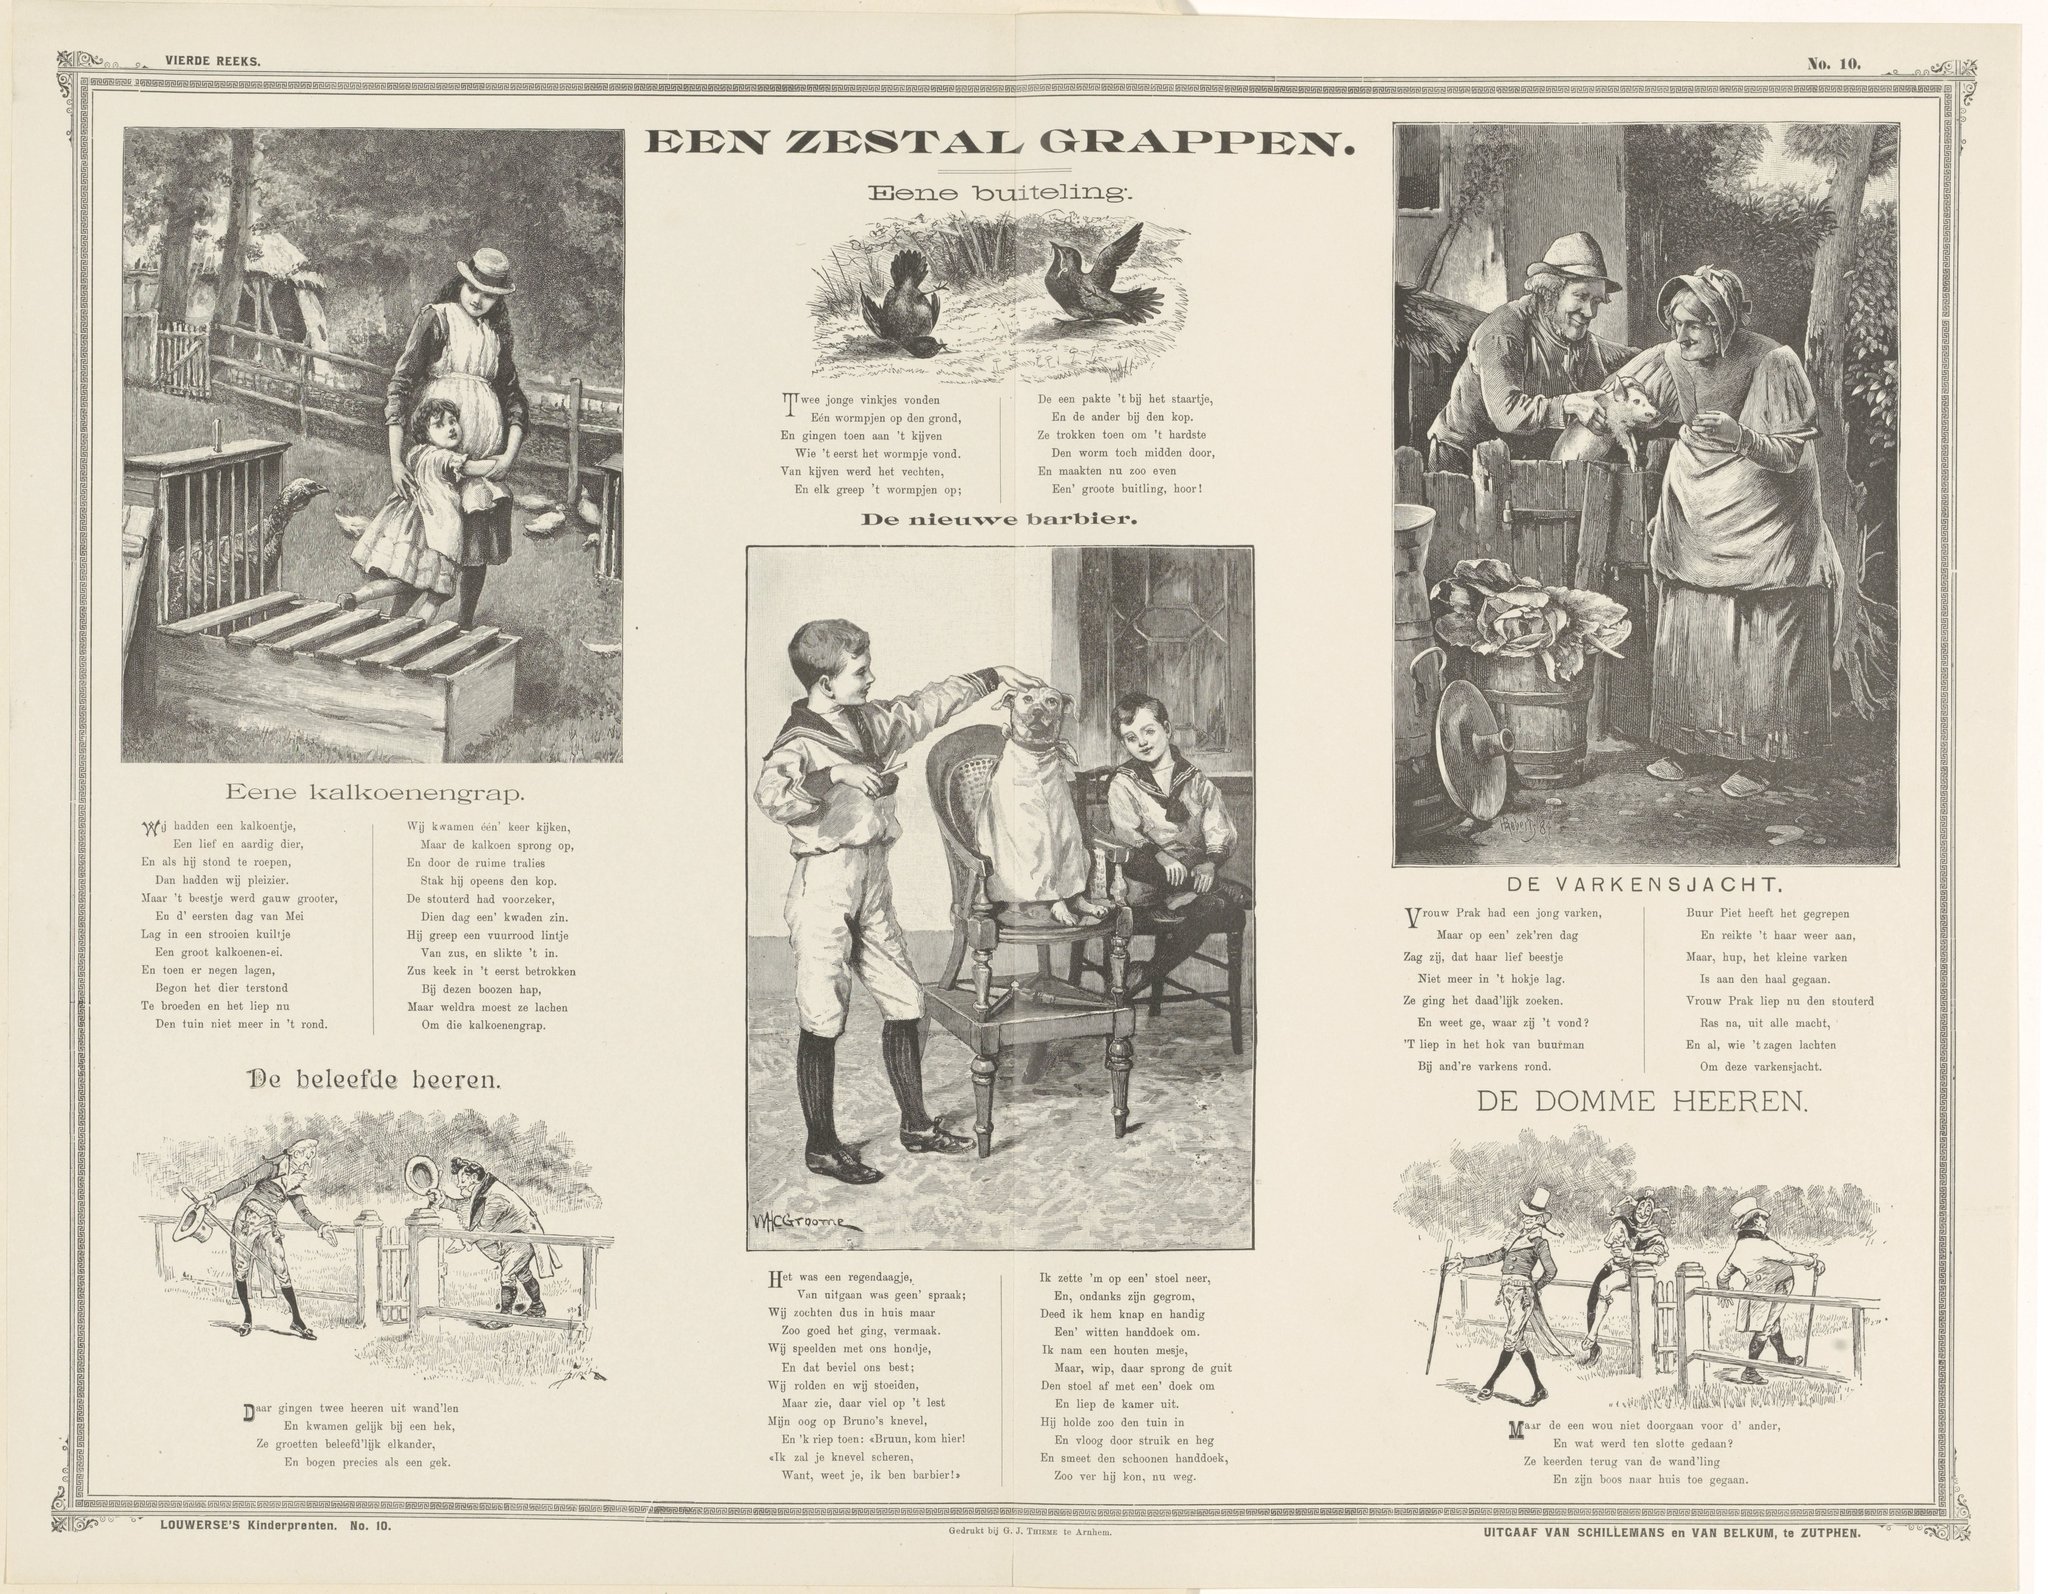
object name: print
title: Louwerse's kinderprenten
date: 1905-1924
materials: paper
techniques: letterpress printing, printing block, engraving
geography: zutphen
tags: birds, shaving, being shaved, comedy, walker and runner birds: turkey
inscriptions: collector's mark: Lugt 2760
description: Blad met 6 komische voorstellingen, waaronder twee jongens die een hond scheren en twee beleefde heren die erop staan elkaar voor te laten gaan. Tussen de afbeeldingen versjes in boekdruk. Genummerd rechtsboven en linksonder: No. 10.